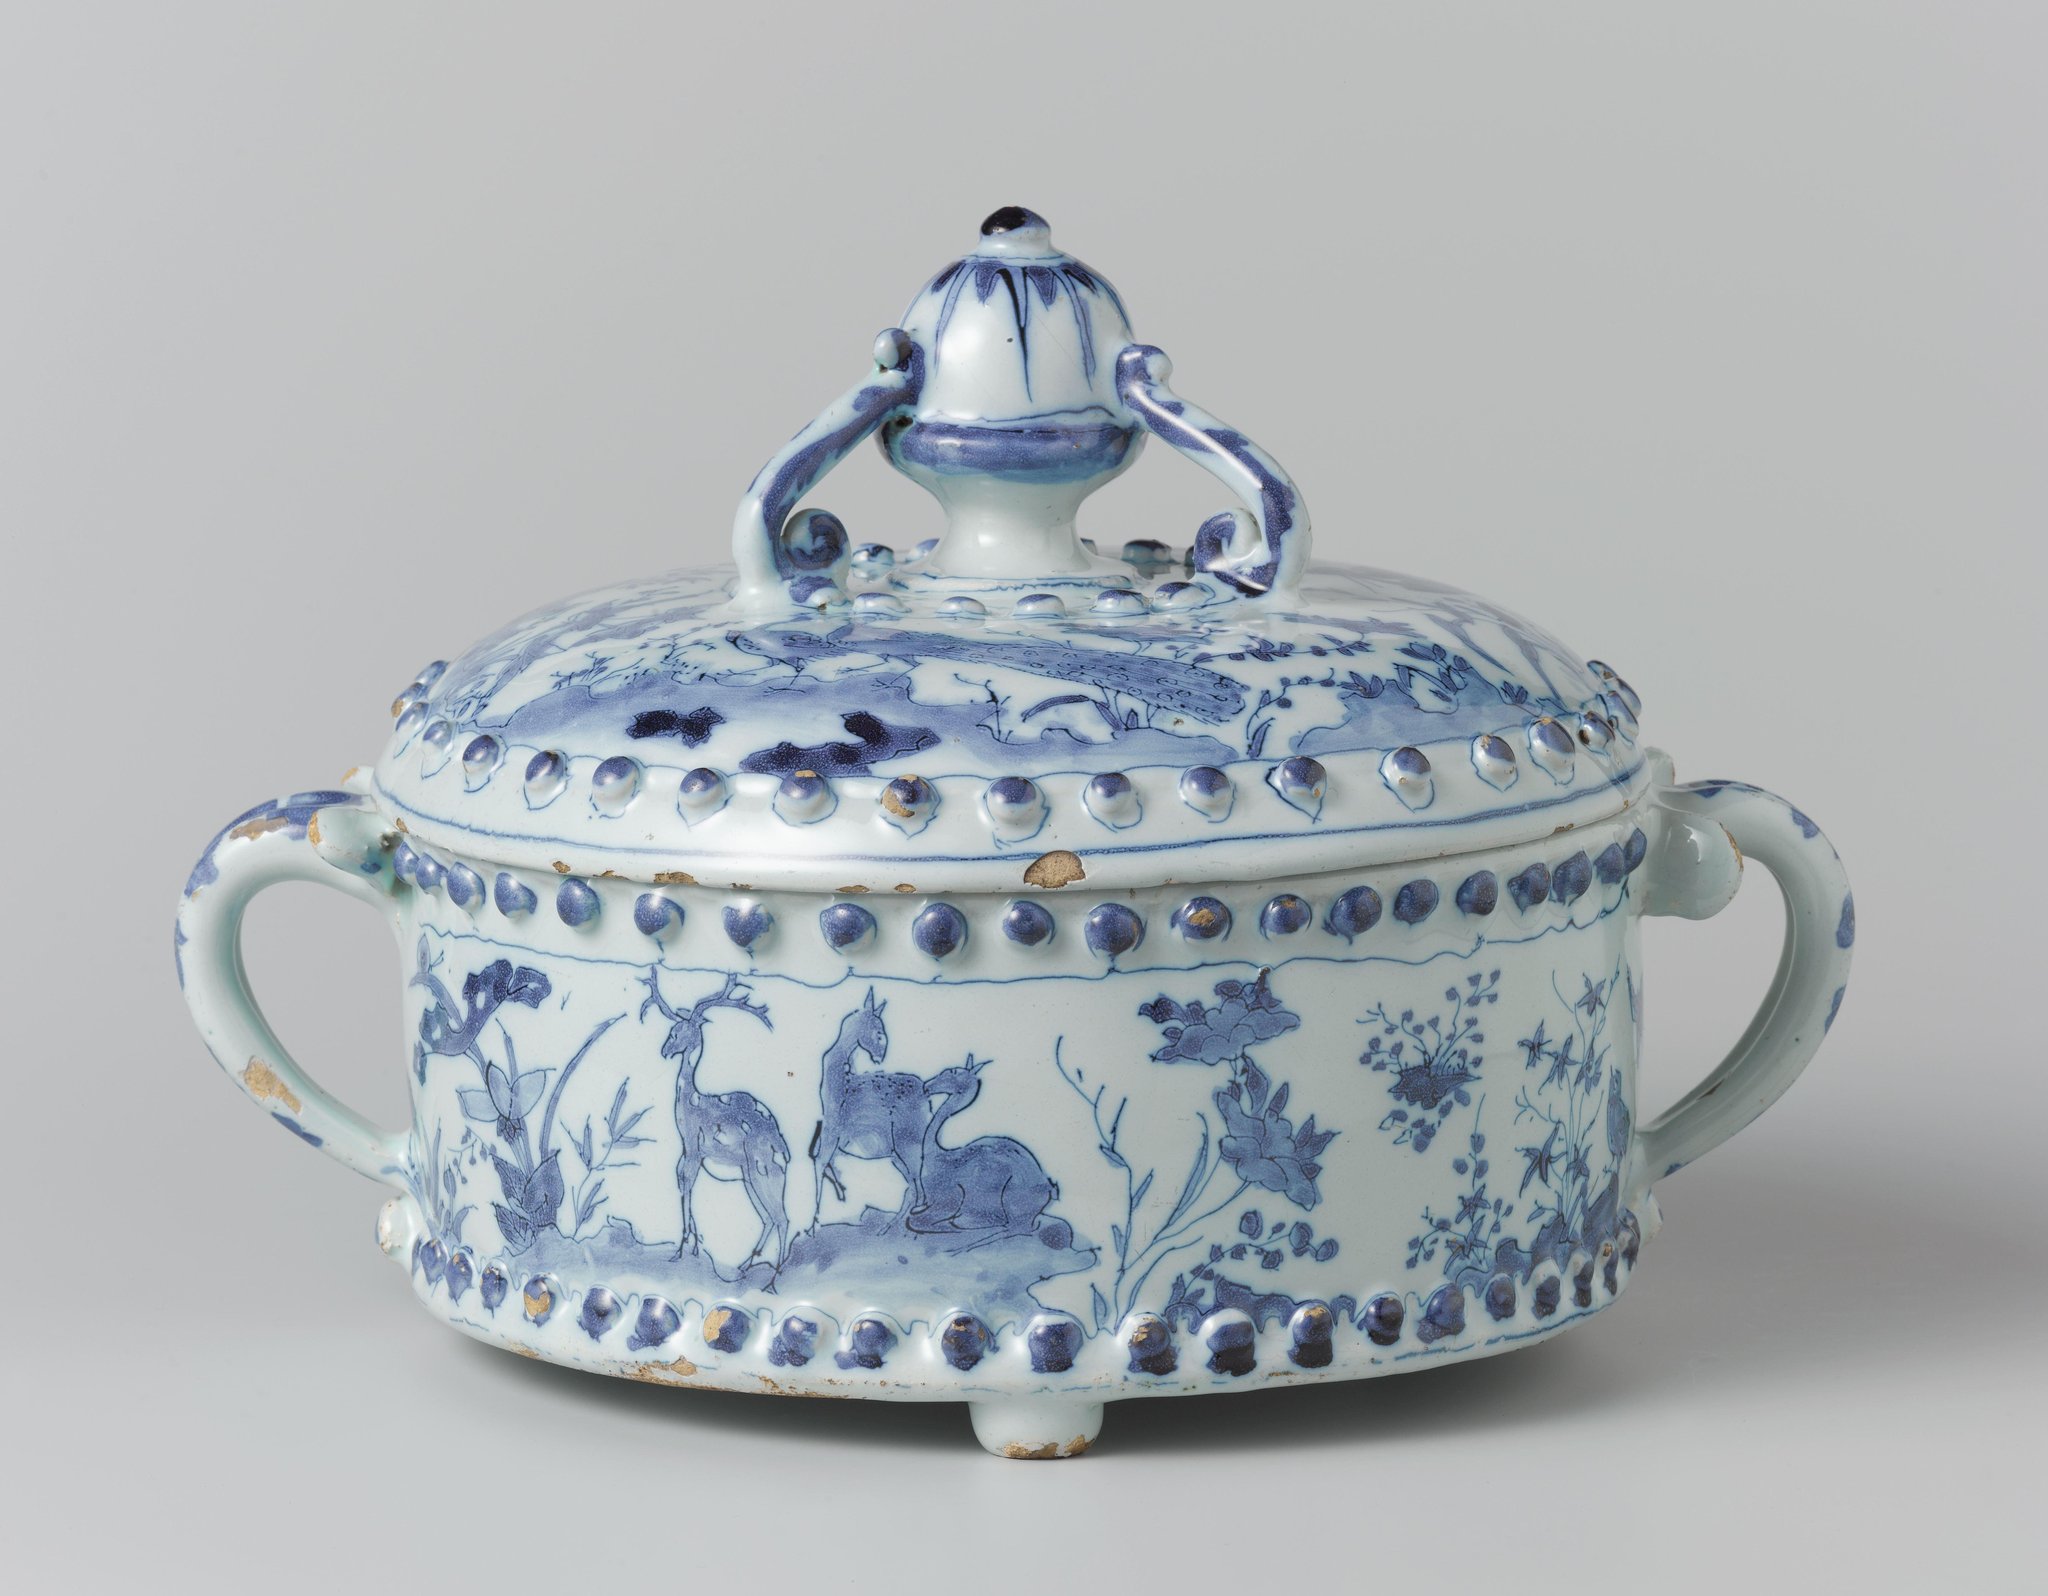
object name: specerijpot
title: Spice Pot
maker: Anonymous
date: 1660-1680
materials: faience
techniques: painted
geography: delft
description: Specerijenpot van faience, blauw beschilderd in het glazuur met een chinoiseriedecoratie. De cilindervormige pot, met twee c-vormige oren, rust op drie poten. Langs onder- en bovenrand van het lichaam een doorlopende rij gladde, bolle noppen.